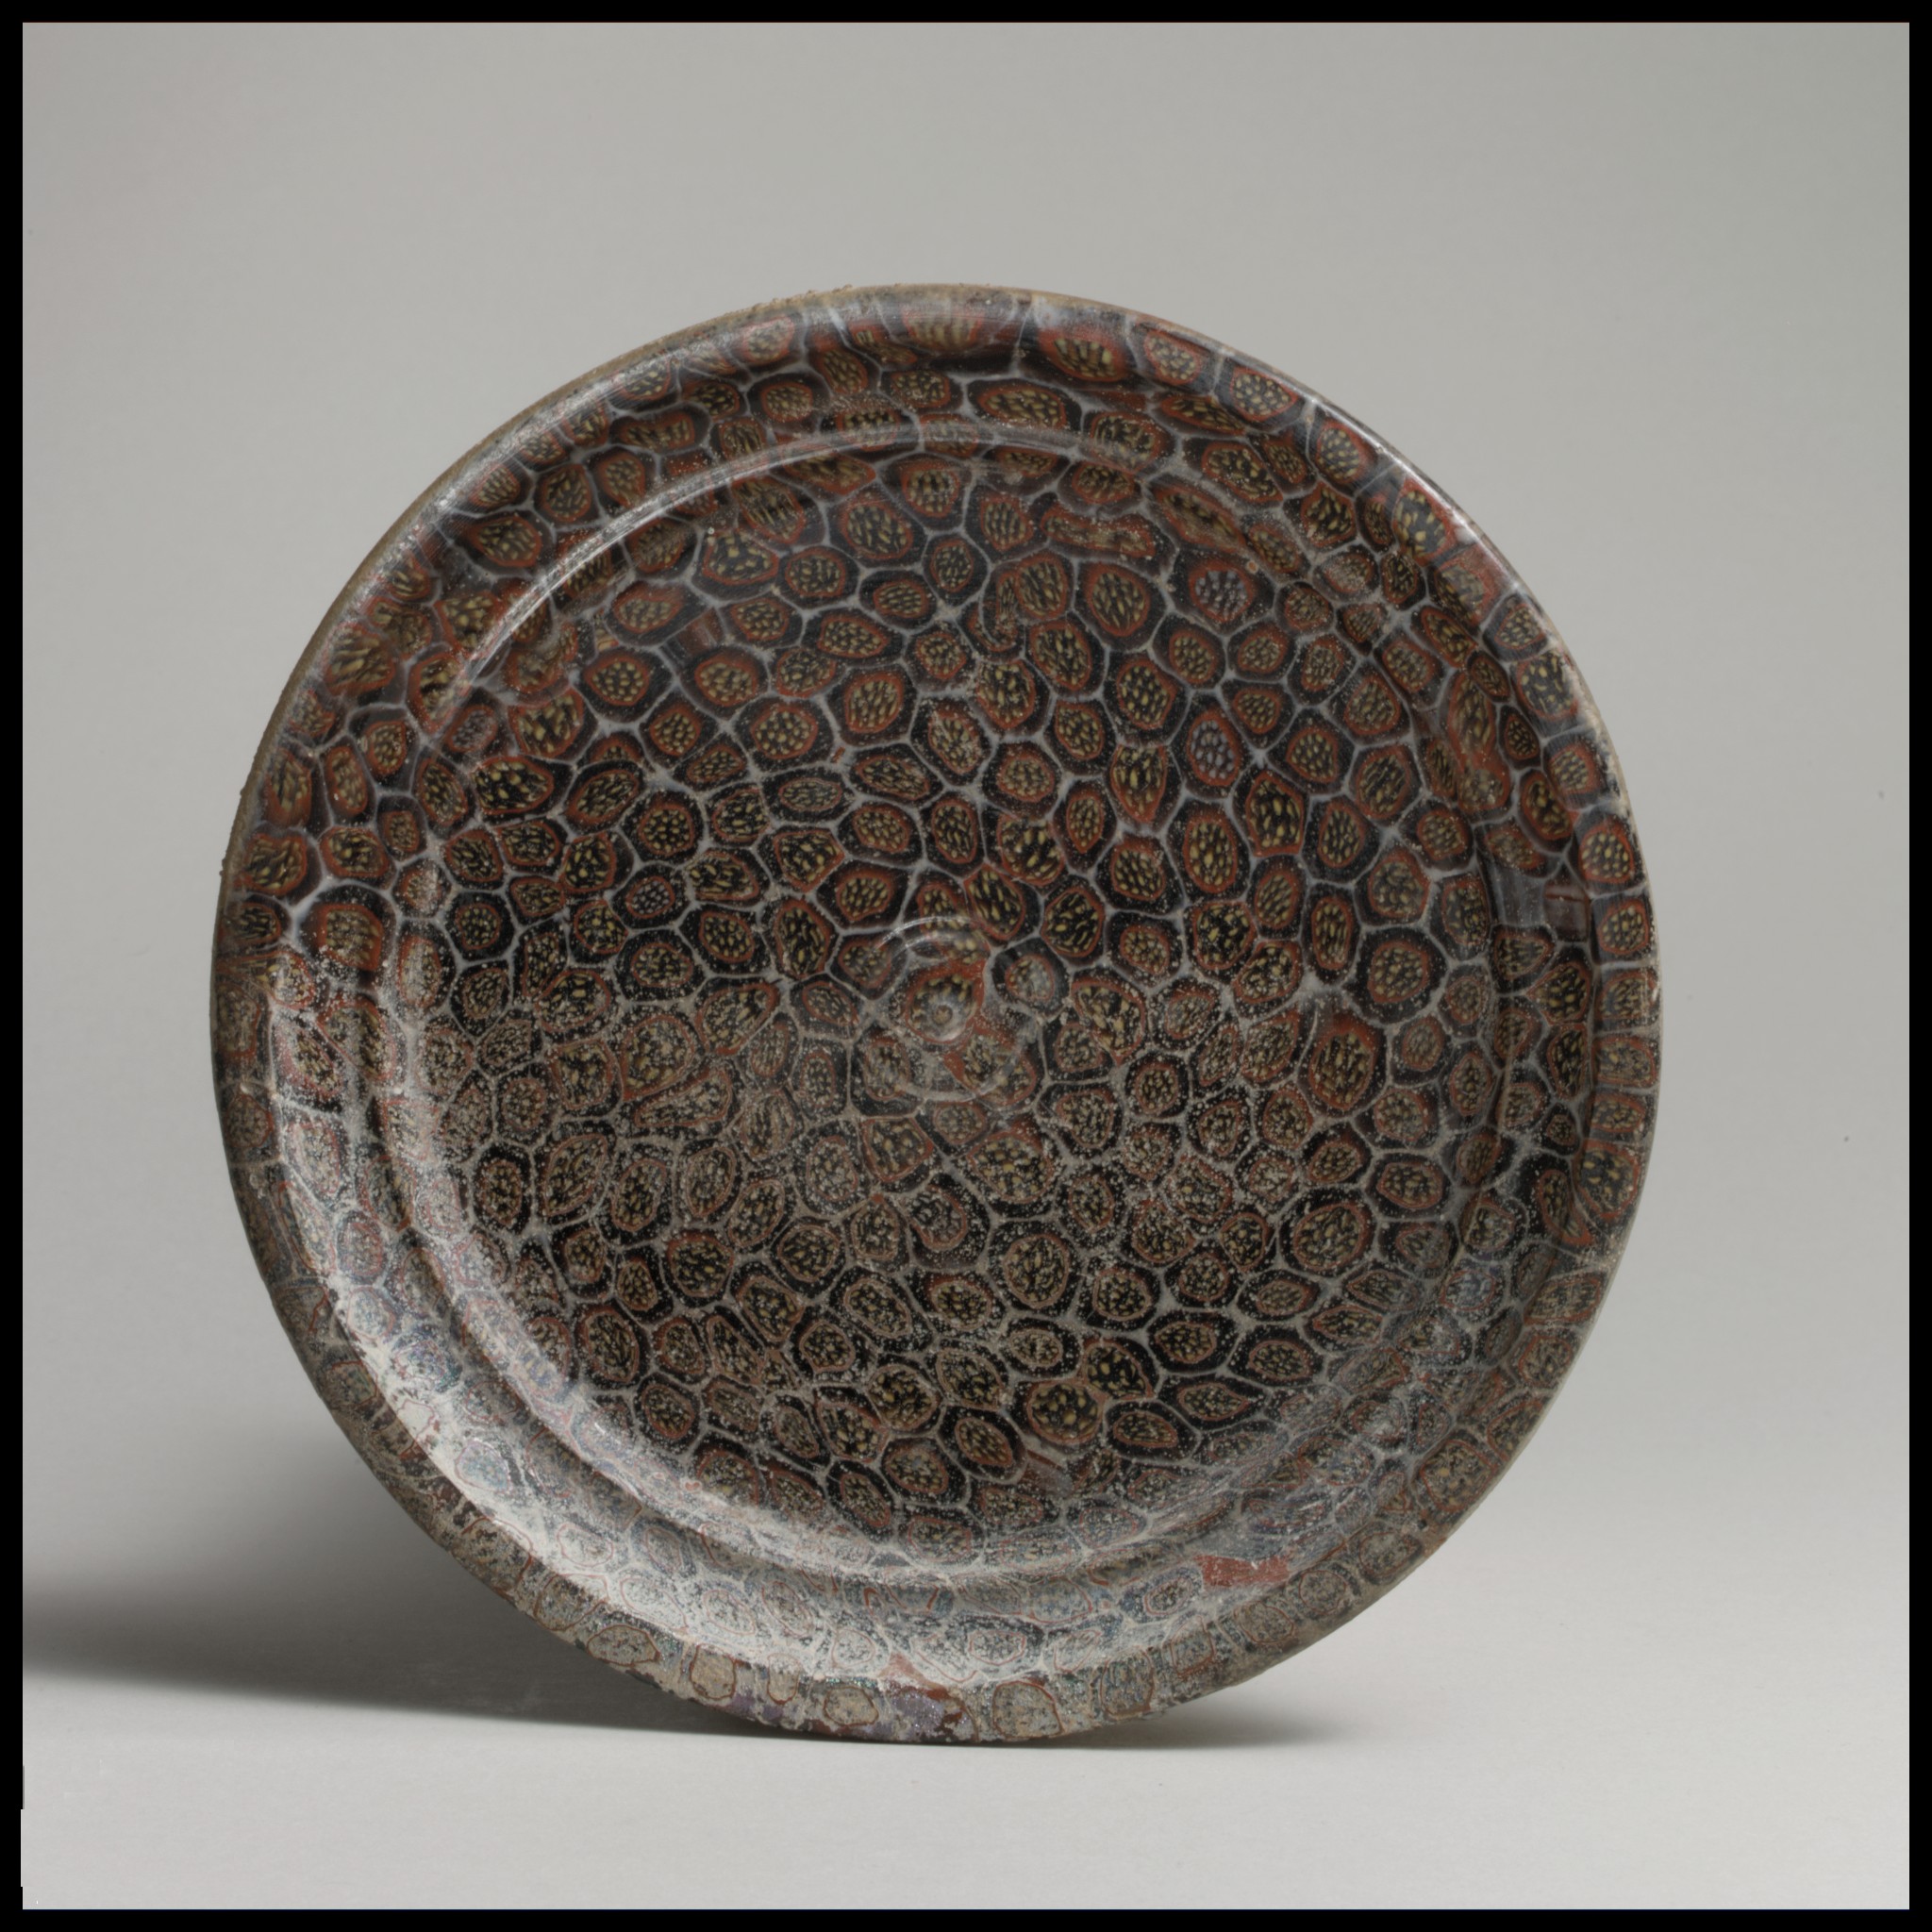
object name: mosaic dish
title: Glass mosaic dish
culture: roman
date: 34 BCE-33 CE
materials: glass